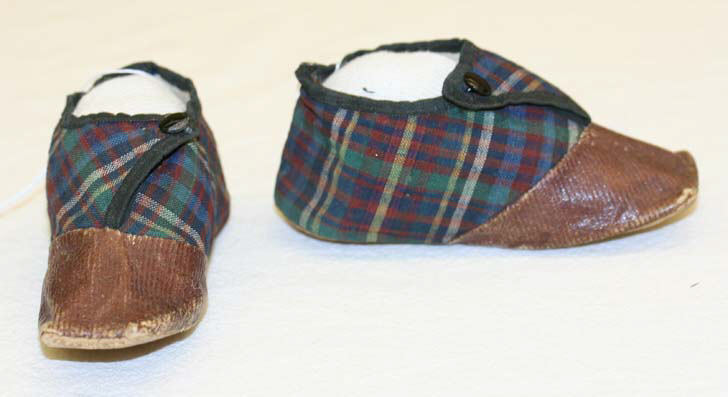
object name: shoe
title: Shoes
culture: american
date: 1860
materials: cotton, leather